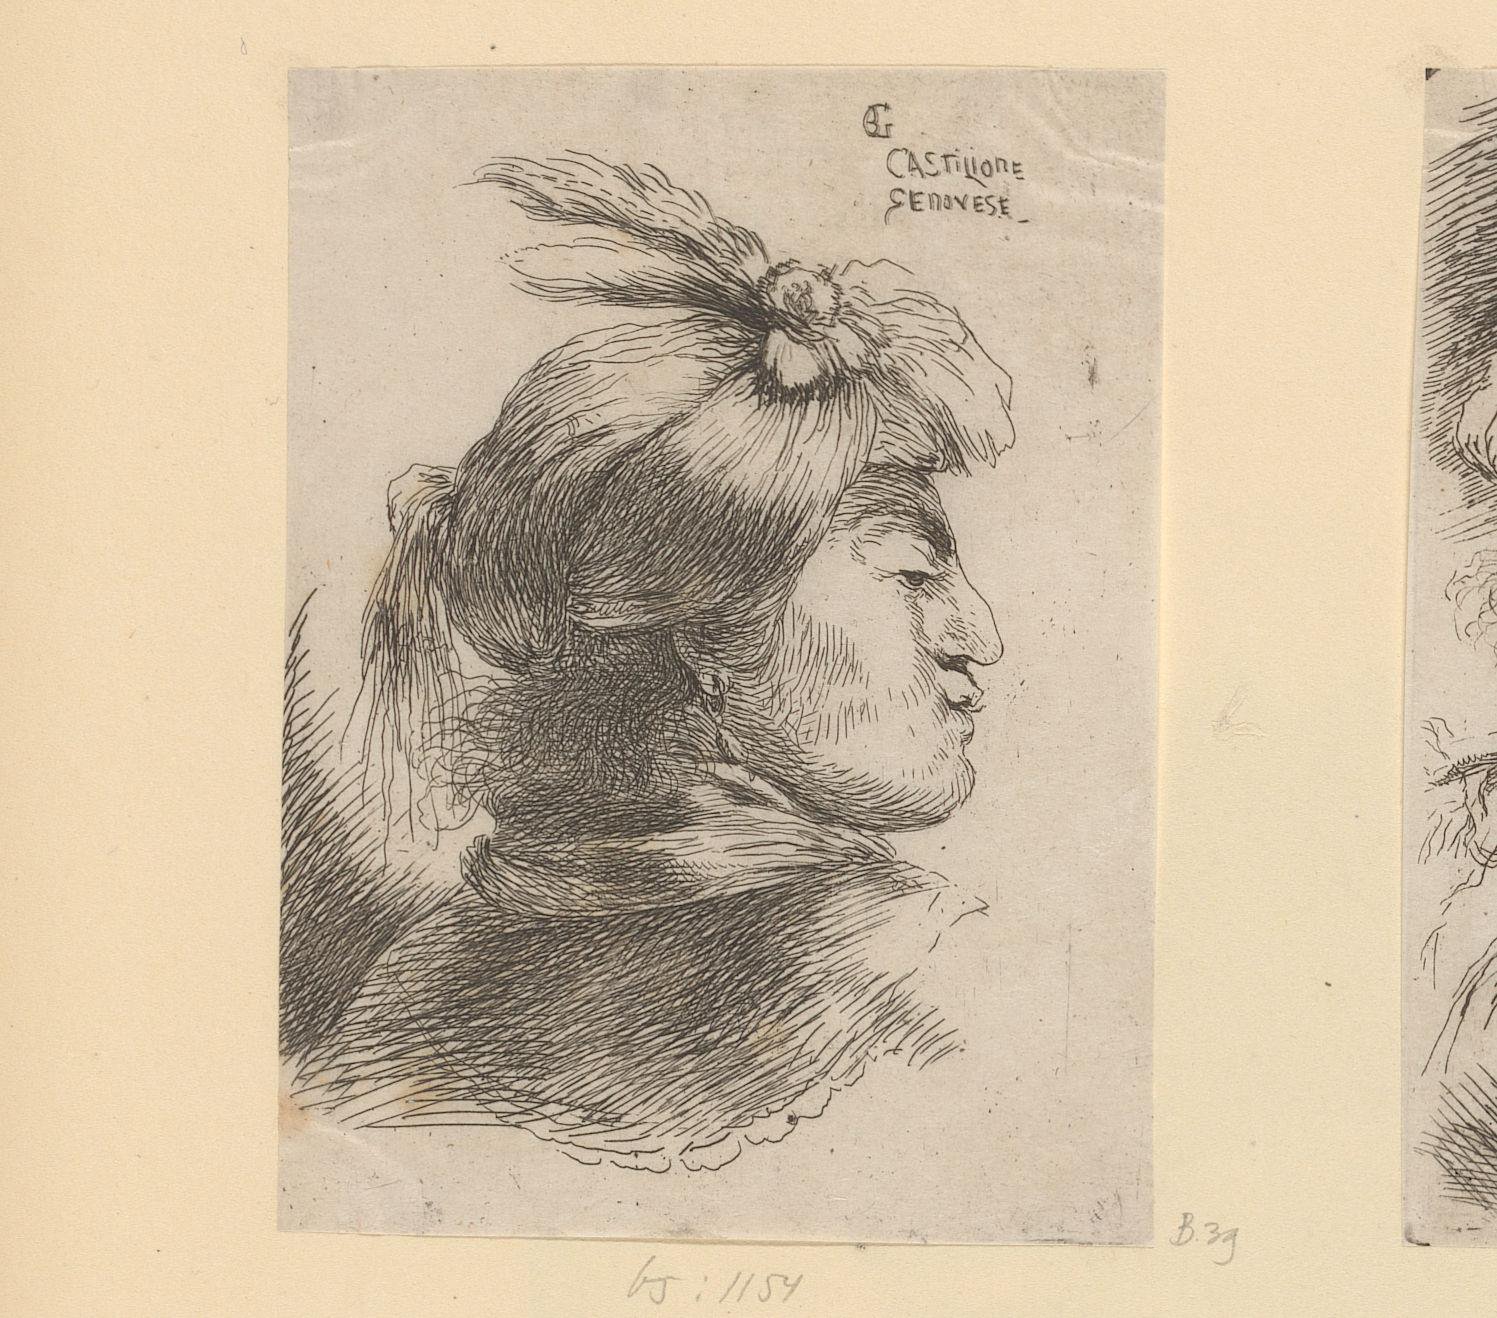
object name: print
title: Kleine studie van hoofden met oosterse hoofddeksels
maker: giovanni benedetto castiglione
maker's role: draughtsman, print maker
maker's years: 1610-1665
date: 1645-1650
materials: paper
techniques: etching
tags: head (human), head-gear: turban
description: Prent is onderdeel van een serie van zestien prenten. Prent maakt mogelijk deel uit van een serie van 200 prenten. Deze serie is onder de titel 'A Collection of two hundred original etchings' voor het eerst uitgegeven door J.M. Greery in 1816.